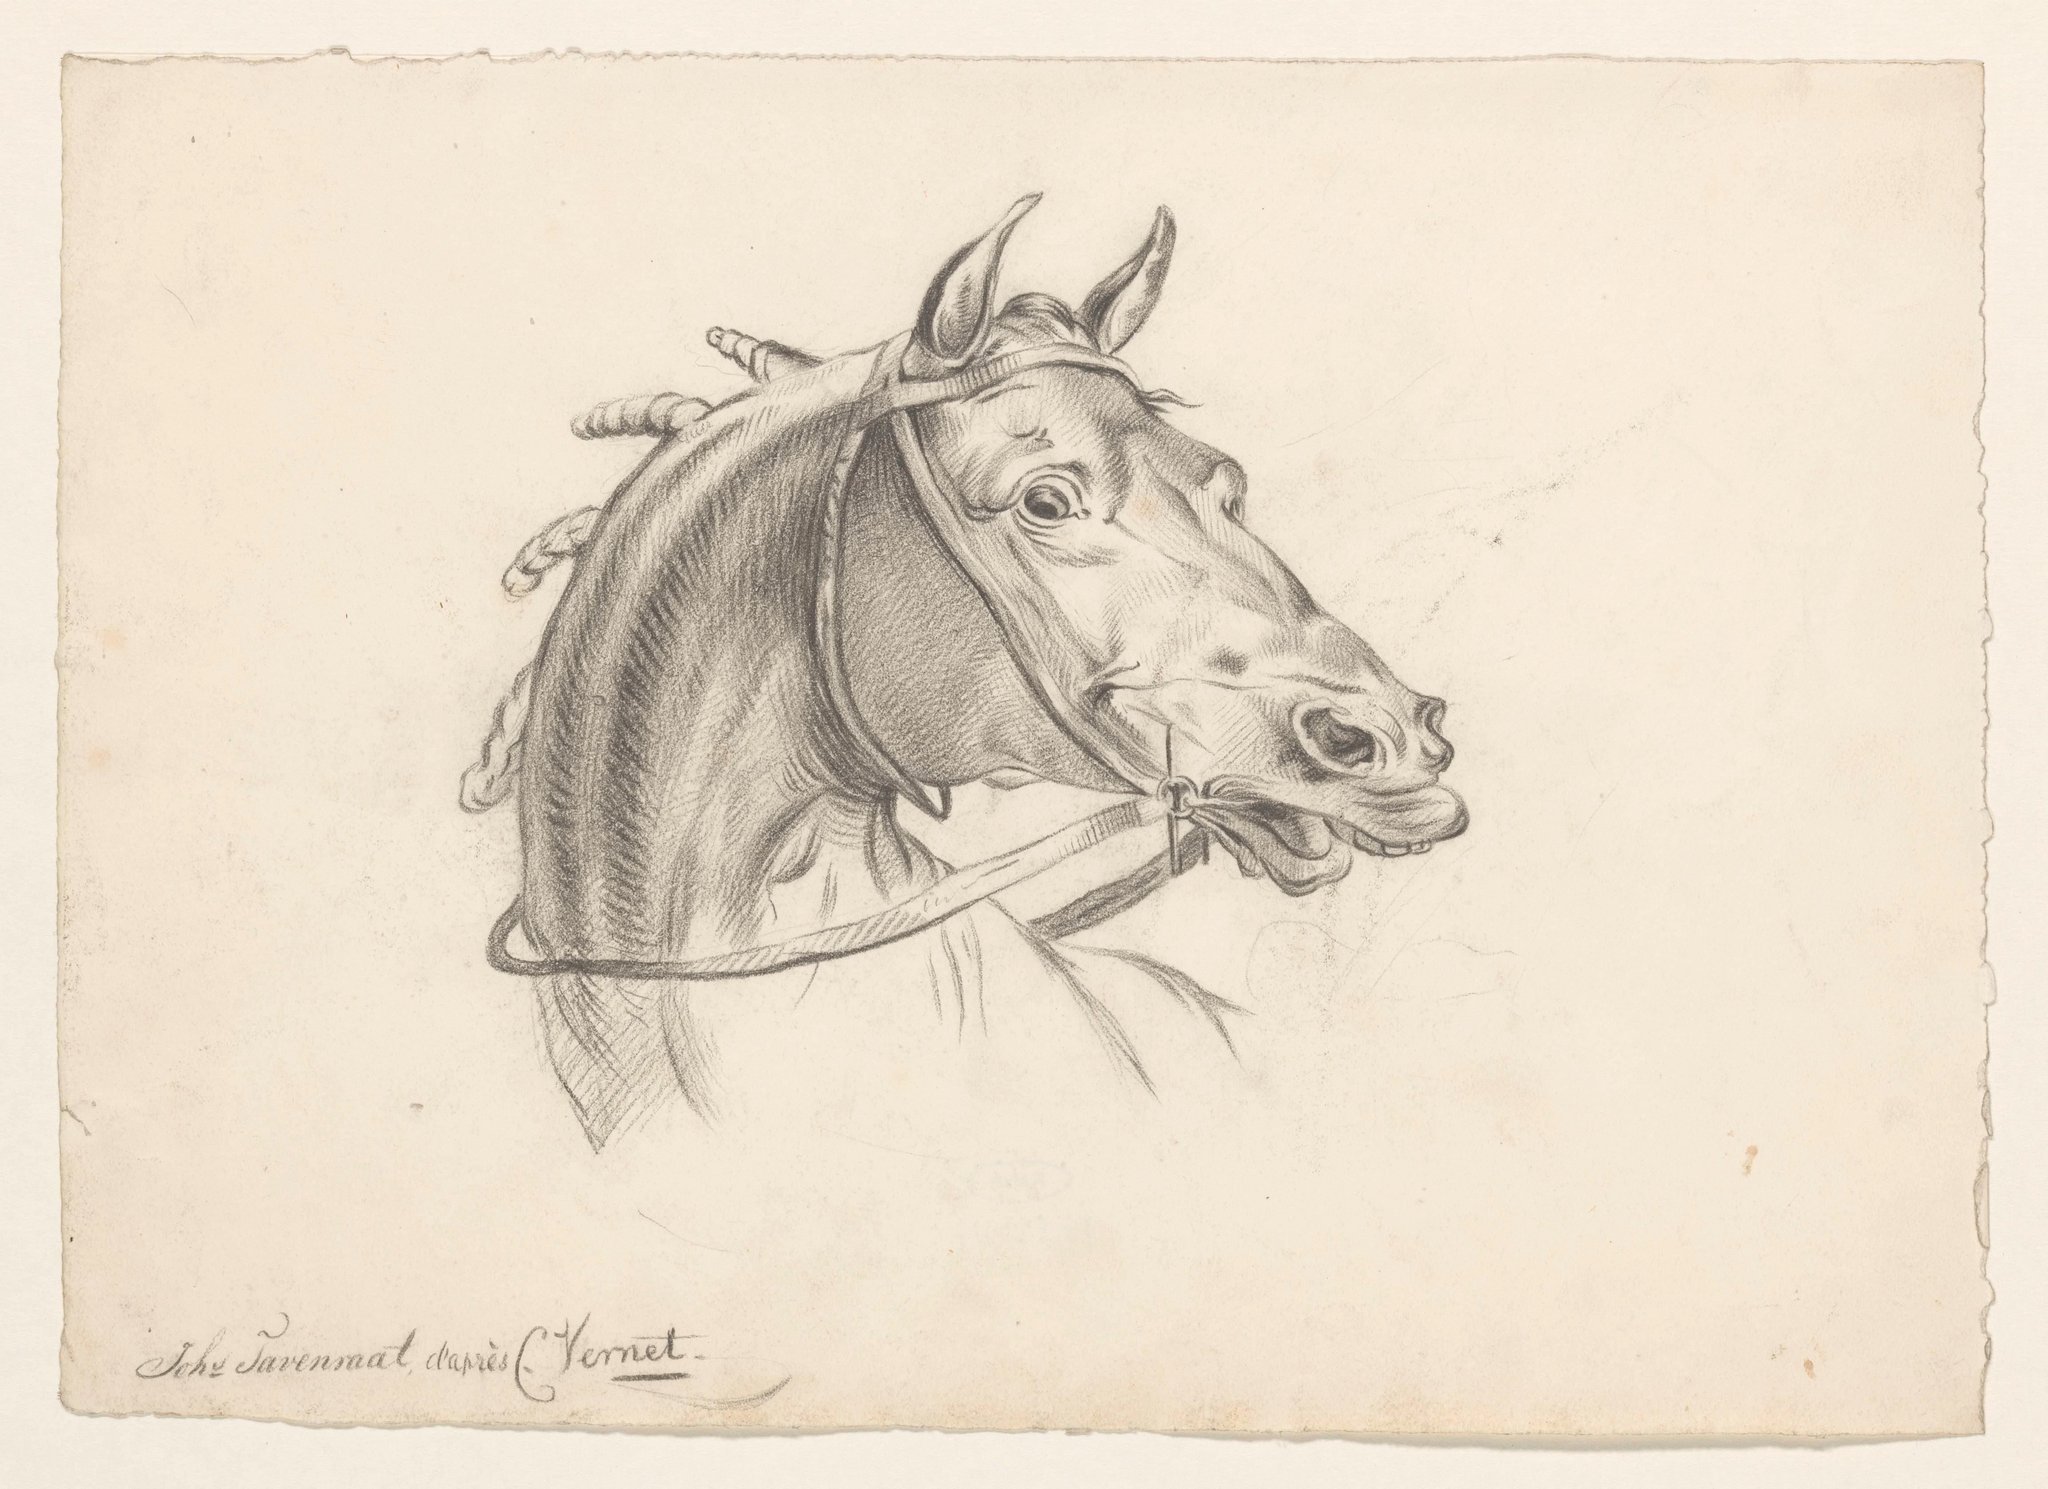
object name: drawing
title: Paardenkop, naar rechts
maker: johannes tavenraat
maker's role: draughtsman, painter, print maker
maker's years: 1809-1881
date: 1819-1881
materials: chalk, paper, pencil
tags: horse